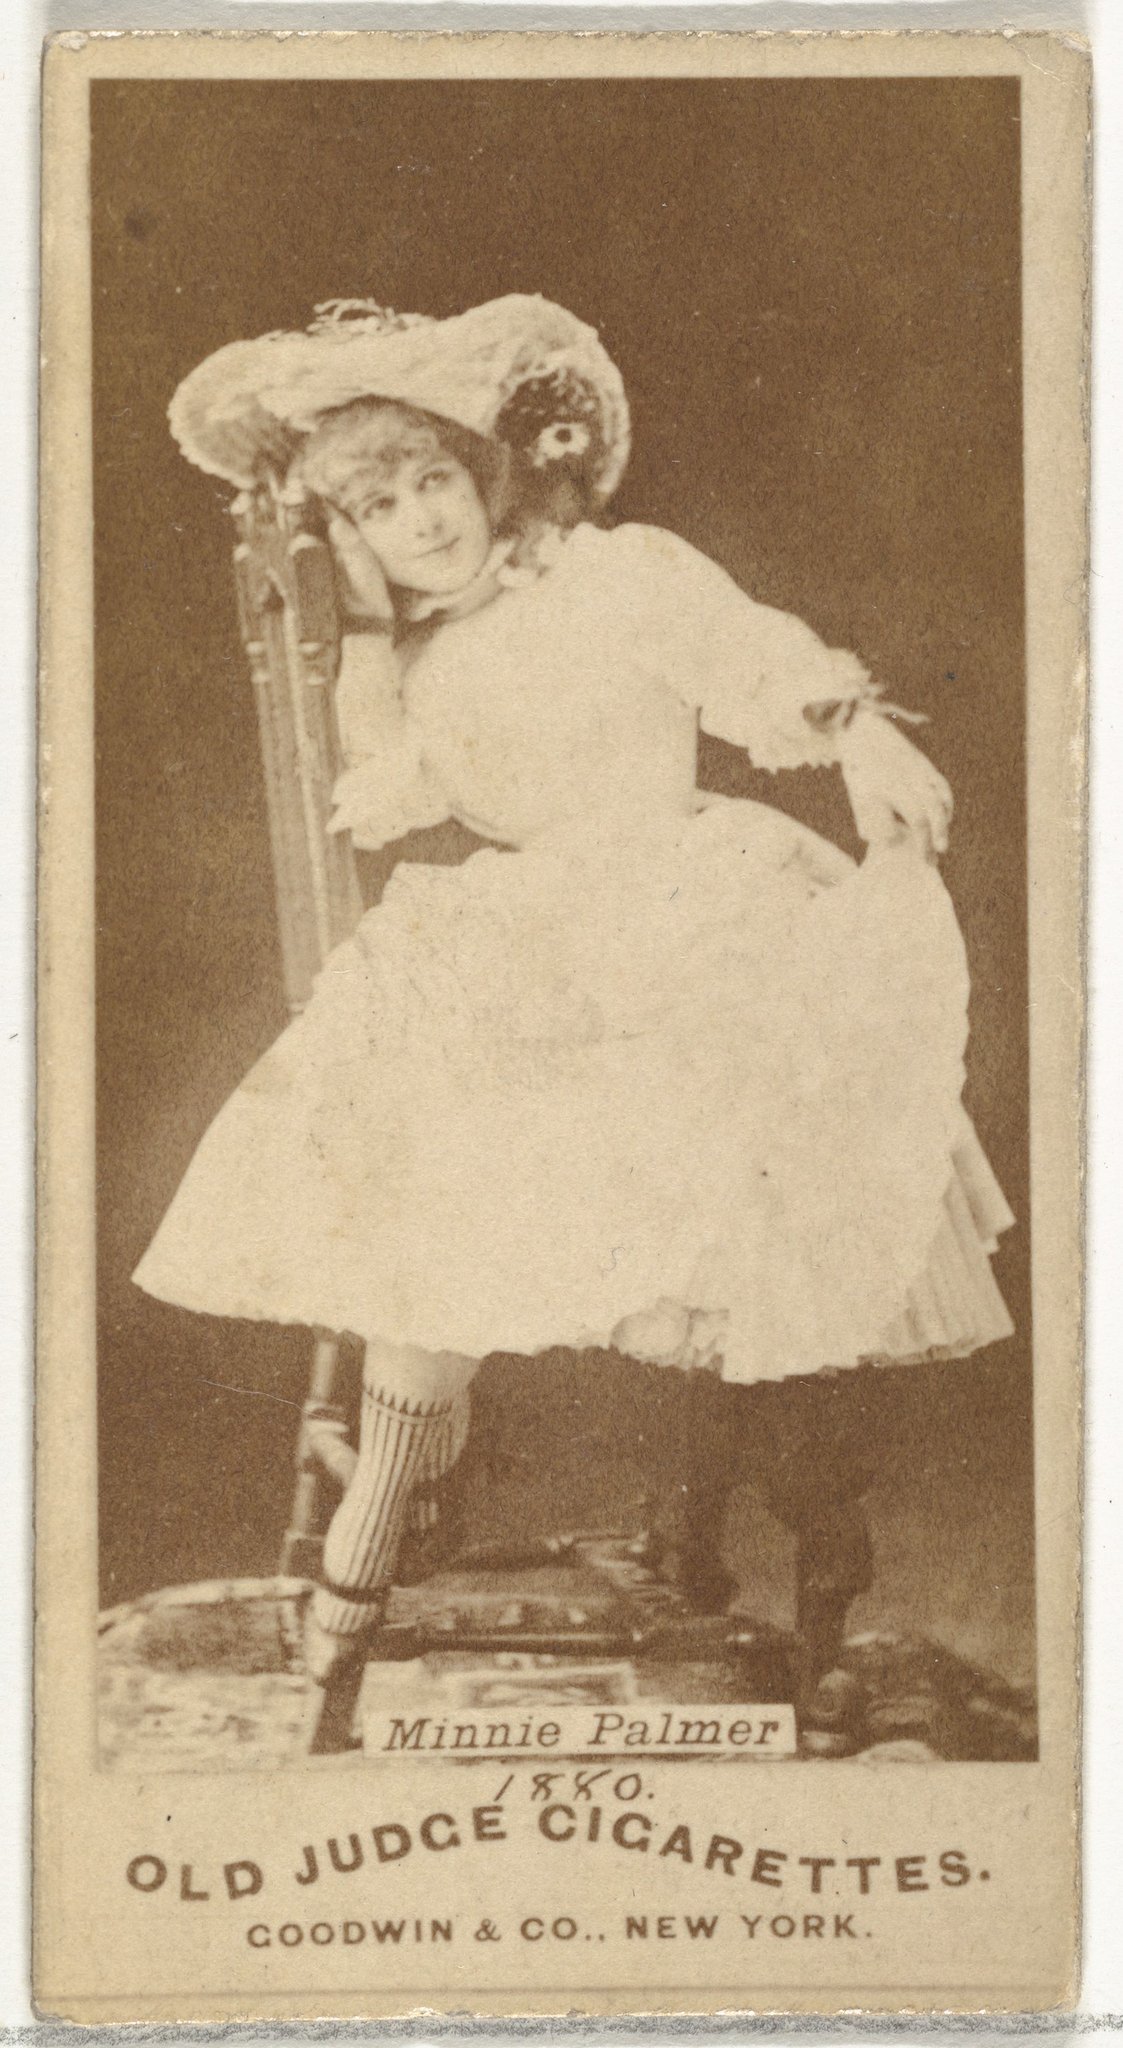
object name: photograph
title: Minnie Palmer, from the Actors and Actresses series (N171) for Old Judge Cigarettes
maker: goodwin & company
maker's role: publisher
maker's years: 1850-1950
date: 1886-1890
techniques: albumen silver print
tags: portraits,women,actresses